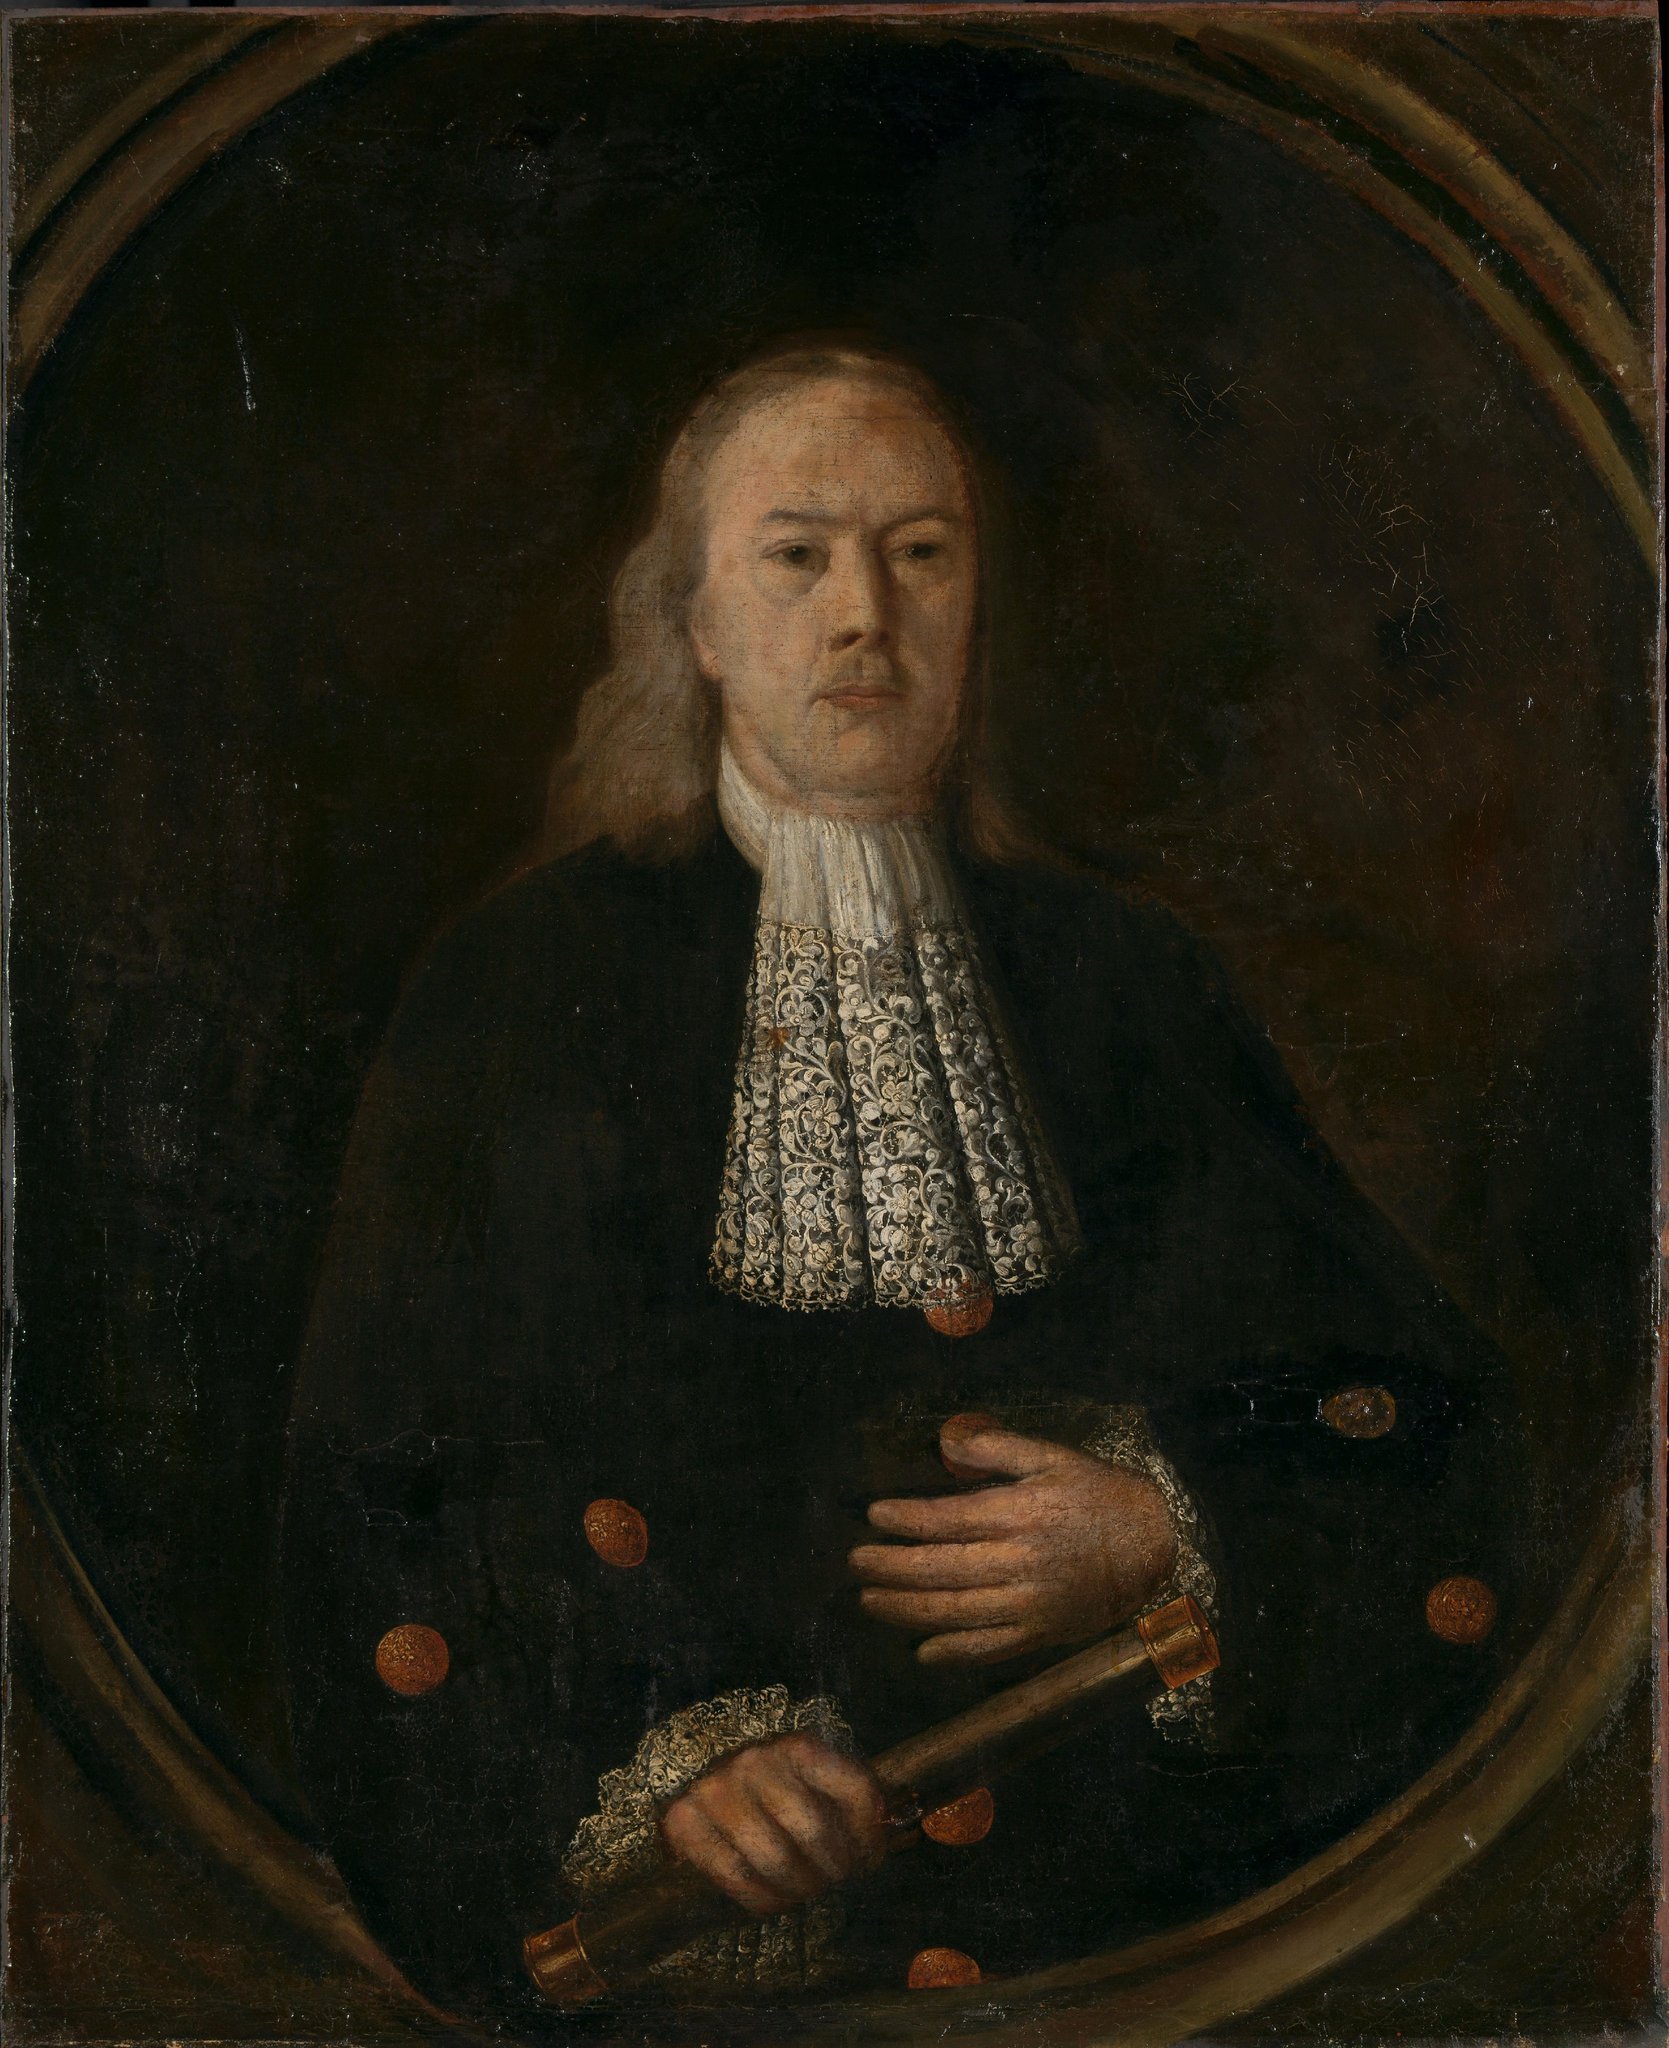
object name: painting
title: Portrait of Abraham van Riebeeck (1653-1713)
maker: Anonymous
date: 1710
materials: canvas, cardboard, oil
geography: batavia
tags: cape of good hope, batavia, colonial governor, historical persons, baton of general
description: The highest-ranking Dutch East India Company (VOC) official in Asia was the governor-general. He presided in the Castle of Batavia (now Jakarta, Indonesia), a fort built by the Dutch. The assembly hall in the Castle of Batavia was the centre of Dutch power in Asia. The walls were hung with portraits of all of the governors-general. Most of the 18th-century examples shown here were painted in Asia, often by anony¬mous artists.